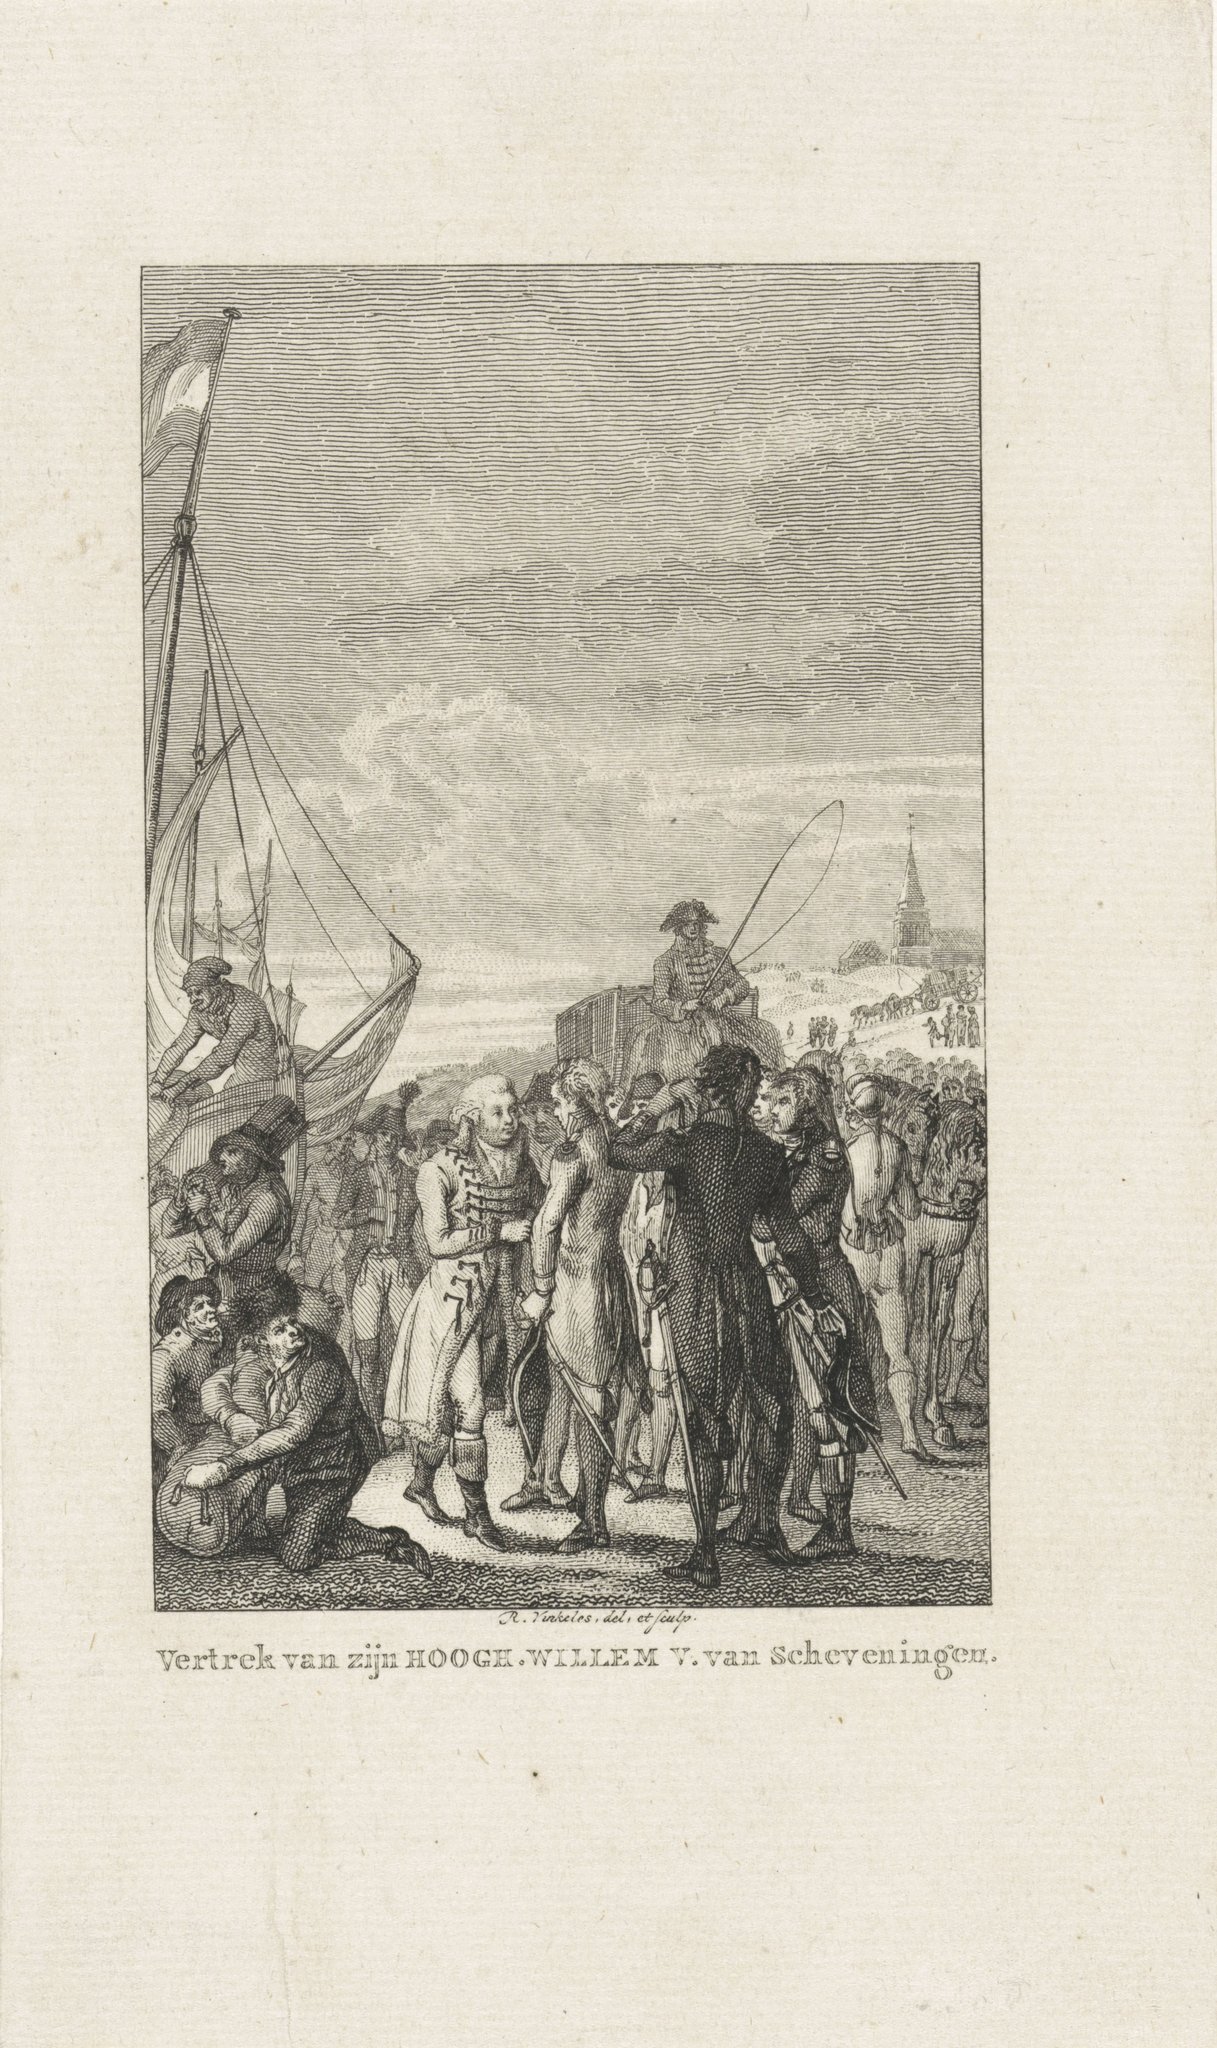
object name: print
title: Vertrek van zijn Hoogh. Willem V. van Scheveningen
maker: reinier vinkeles (i)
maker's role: draughtsman, print maker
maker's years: 1741-1816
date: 1800-1801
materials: paper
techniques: engraving, etching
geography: northern netherlands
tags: william v (prince of orange), departure ~ travelling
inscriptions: collector's mark: Lugt 2228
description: Vertrek van prins Willem V vanaf het strand van Scheveningen naar Engeland, 18 januari 1795. De stadhouder neemt op het strand afscheid van een groep officieren, terwijl bagage aan boord van een visserspink wordt geladen. Op het strand en de duinen veel toegestroomde publiek.